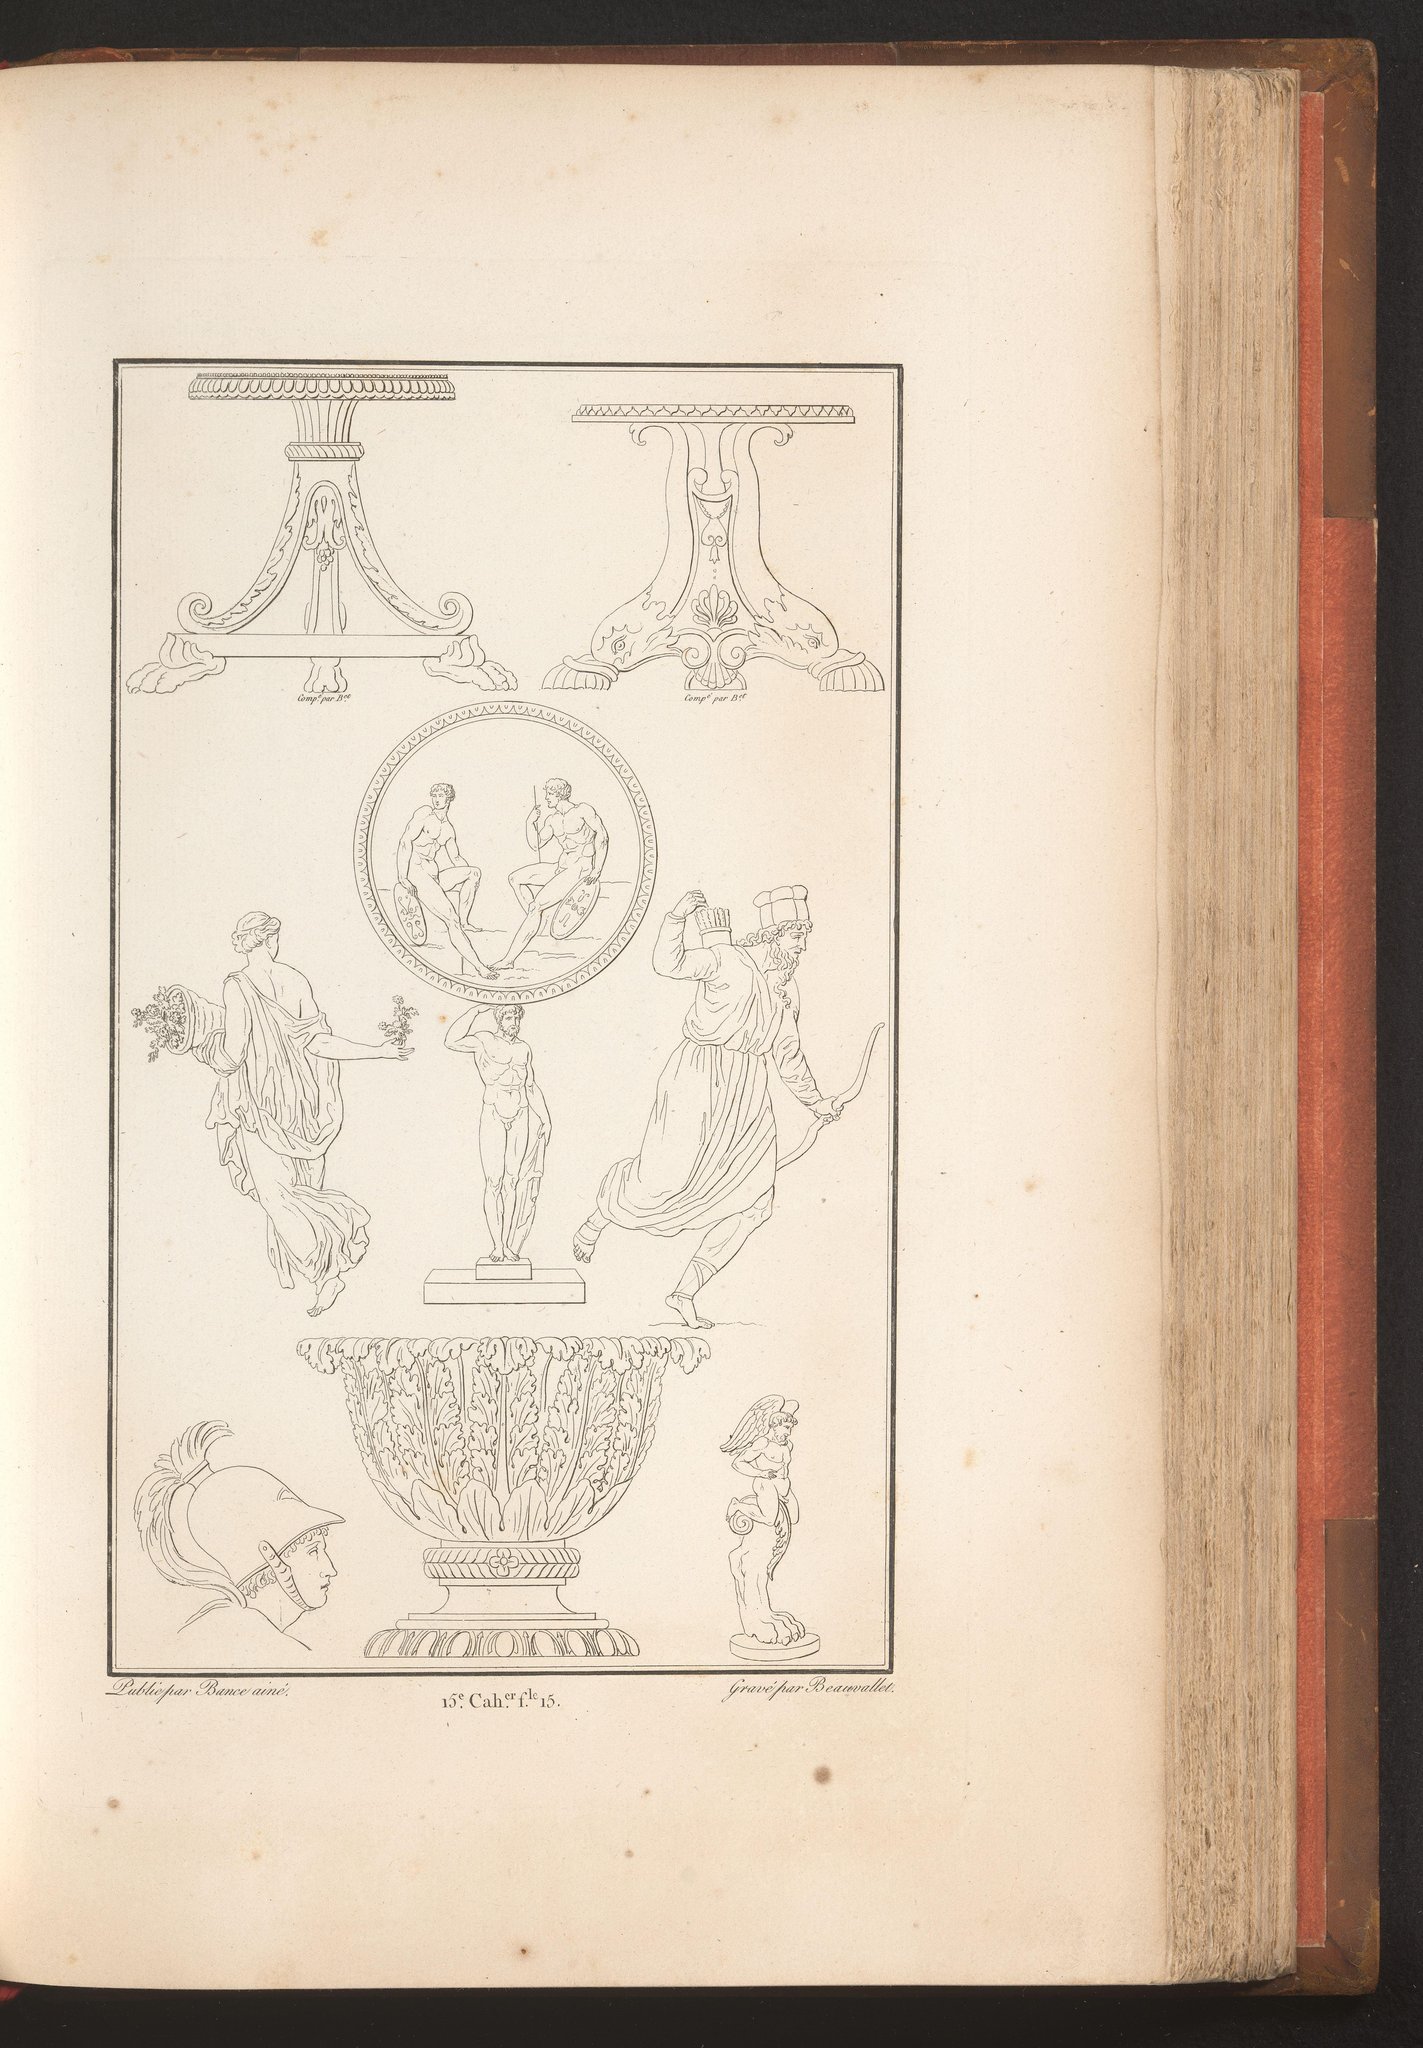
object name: ornament print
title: Tafels en figuren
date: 1820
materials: paper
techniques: etching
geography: paris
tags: ornaments ~ art, table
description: Ornamentprent diverse figuren, bovenaan twee tafels. Onderdeel (15e. Cah. f.le 15) van het prentalbum met twee series van in totaal 138 ornamentprenten door Beauvallet en Normand, 'Fragmens d'Ornemens dans le Style Antique'.